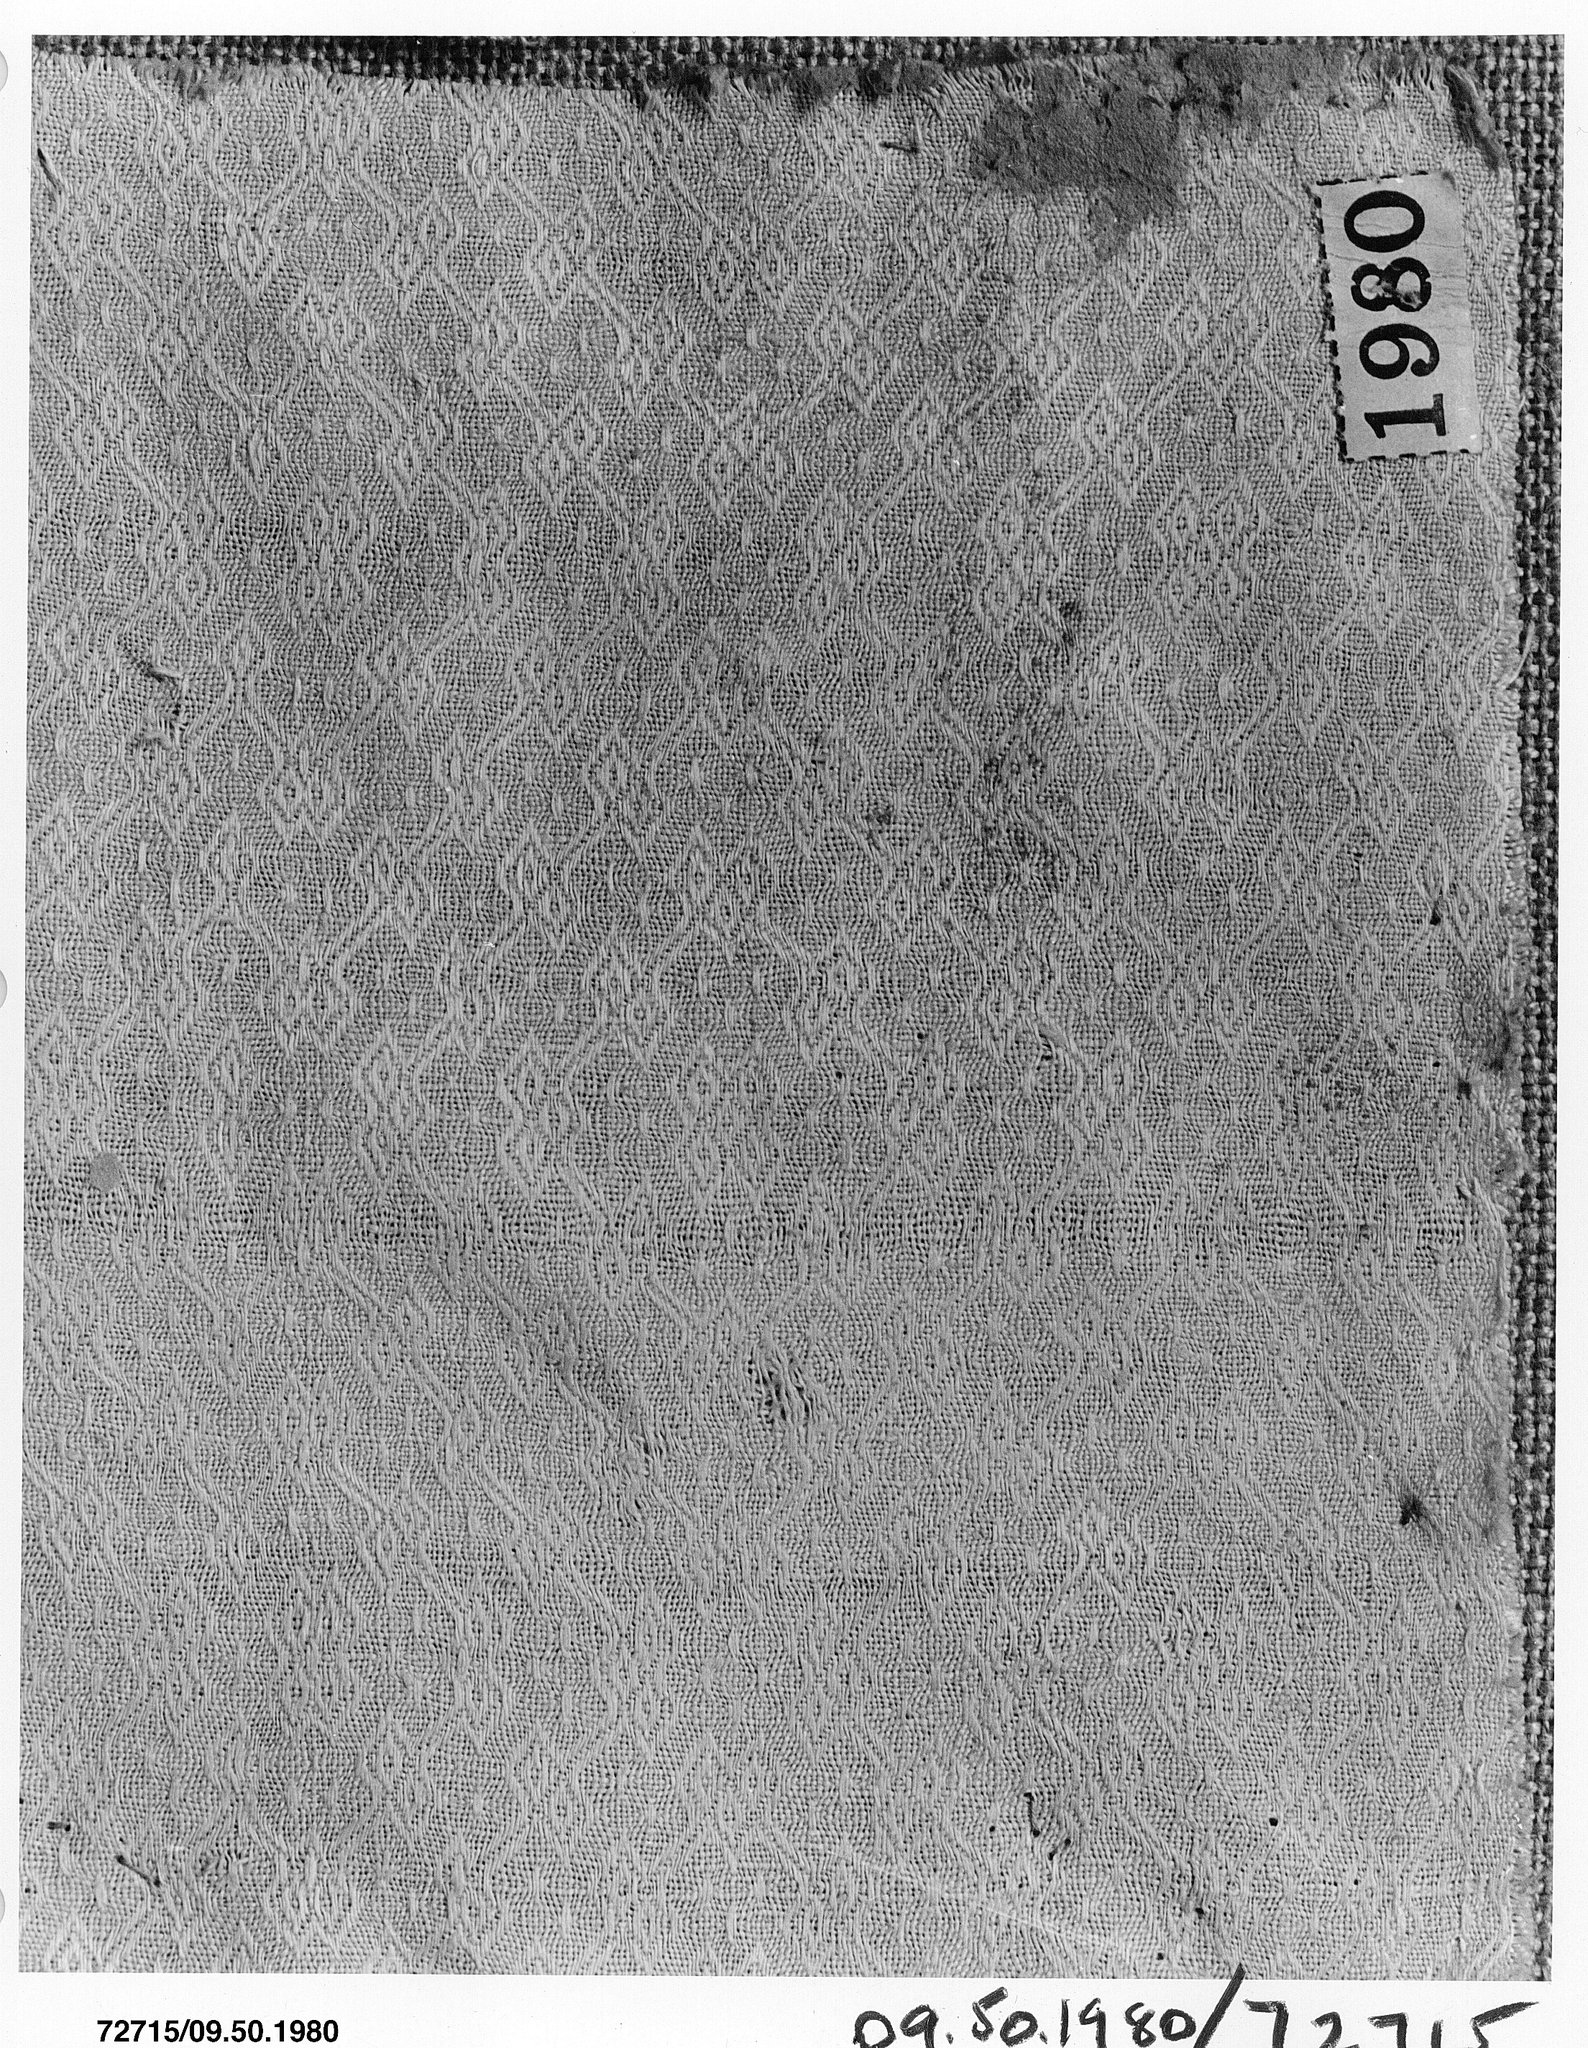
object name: piece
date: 1701-1900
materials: linen